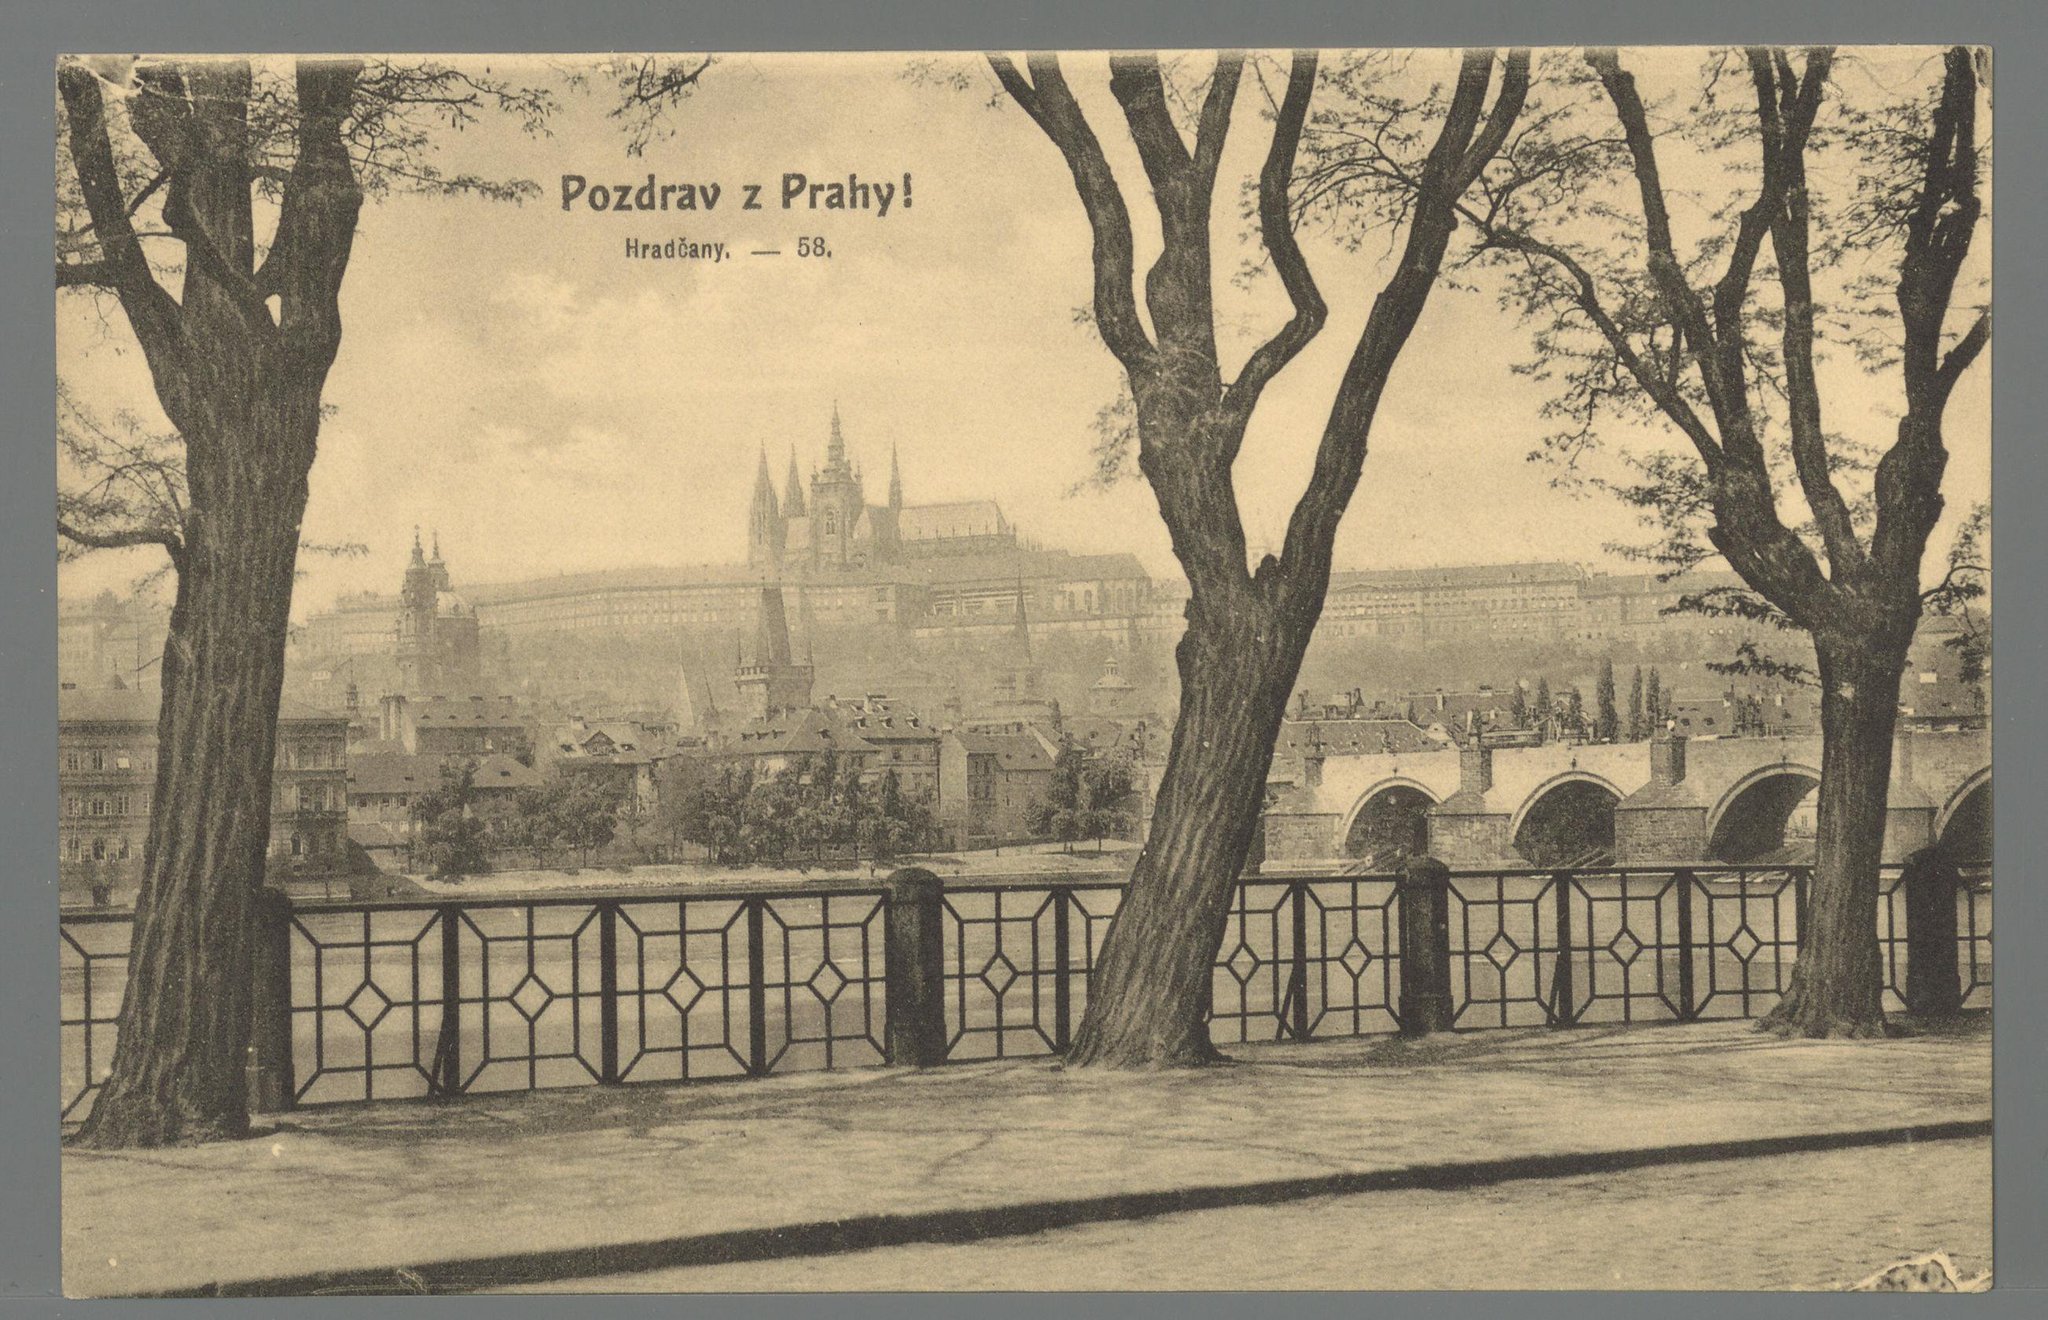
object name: photomechanical print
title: Pozdrav z Prahy! Hradčany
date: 1908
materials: cardboard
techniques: photograph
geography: prague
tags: castle, church (exterior)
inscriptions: date